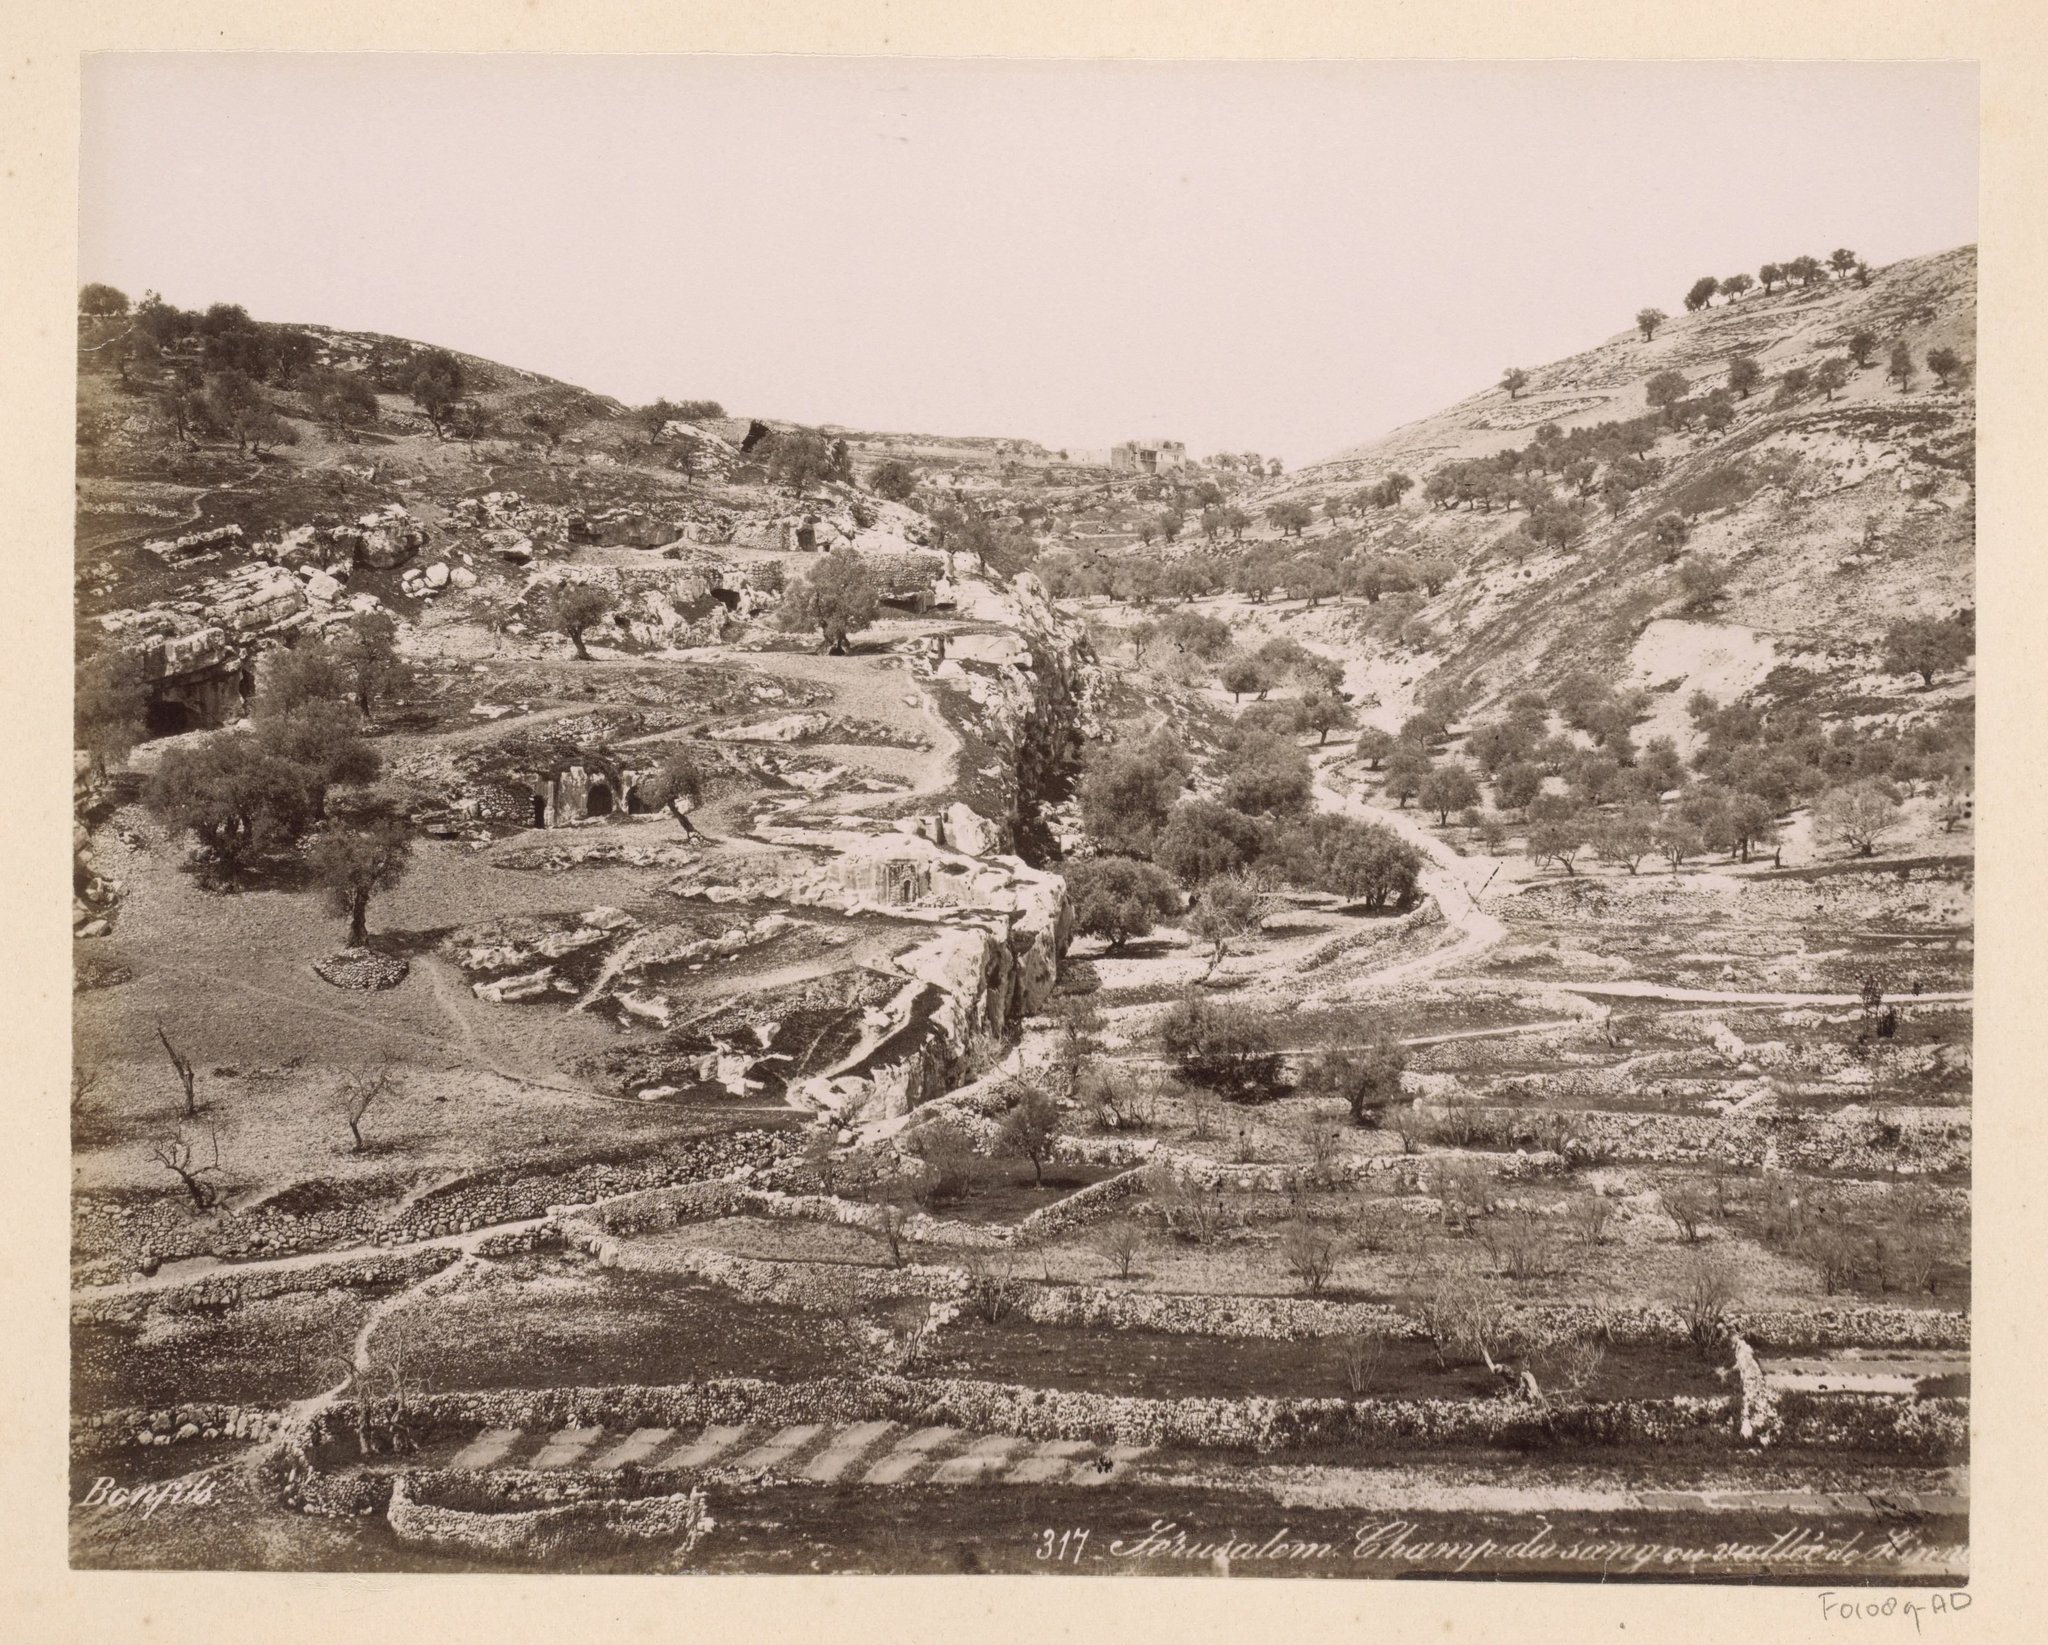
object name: photograph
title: Gezicht op het Dal van Hinnom bij Jeruzalem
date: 1867-1895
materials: cardboard, paper, photographic support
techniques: albumen print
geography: jerusalem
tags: dale, valley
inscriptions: negative number: ‘317’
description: Onderdeel van Reisalbum met foto's van Jeruzalem en andere bijbelse plaatsen.